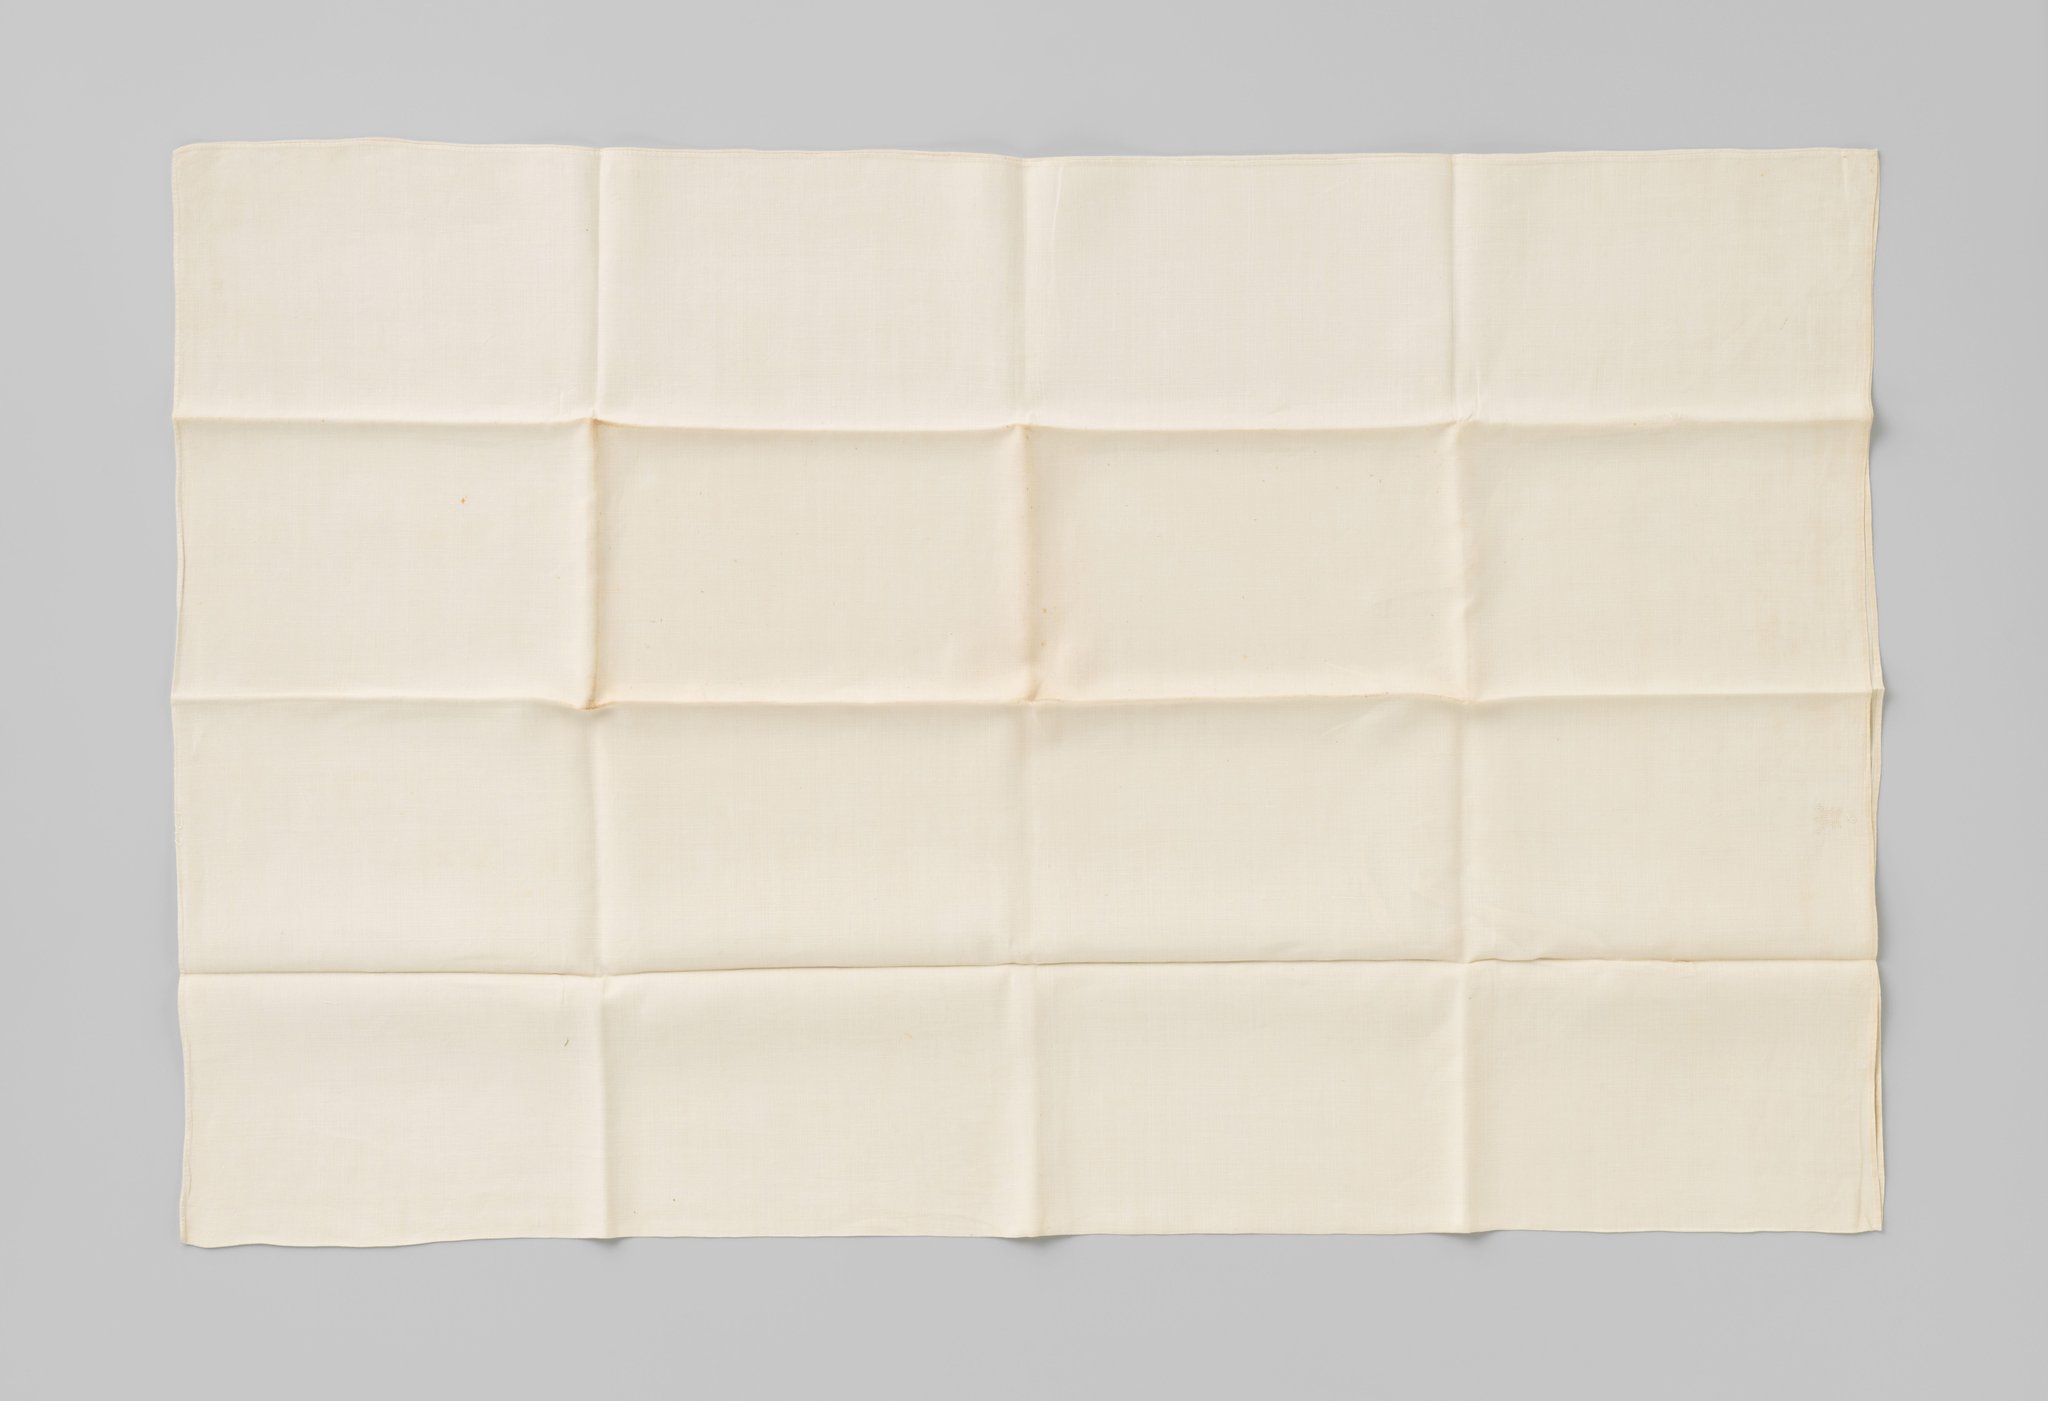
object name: pillowcase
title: Kussensloop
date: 1700-1712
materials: linen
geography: netherlands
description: Wit linnen kussensloop, merk kroon GS 6 WH 2oonl.